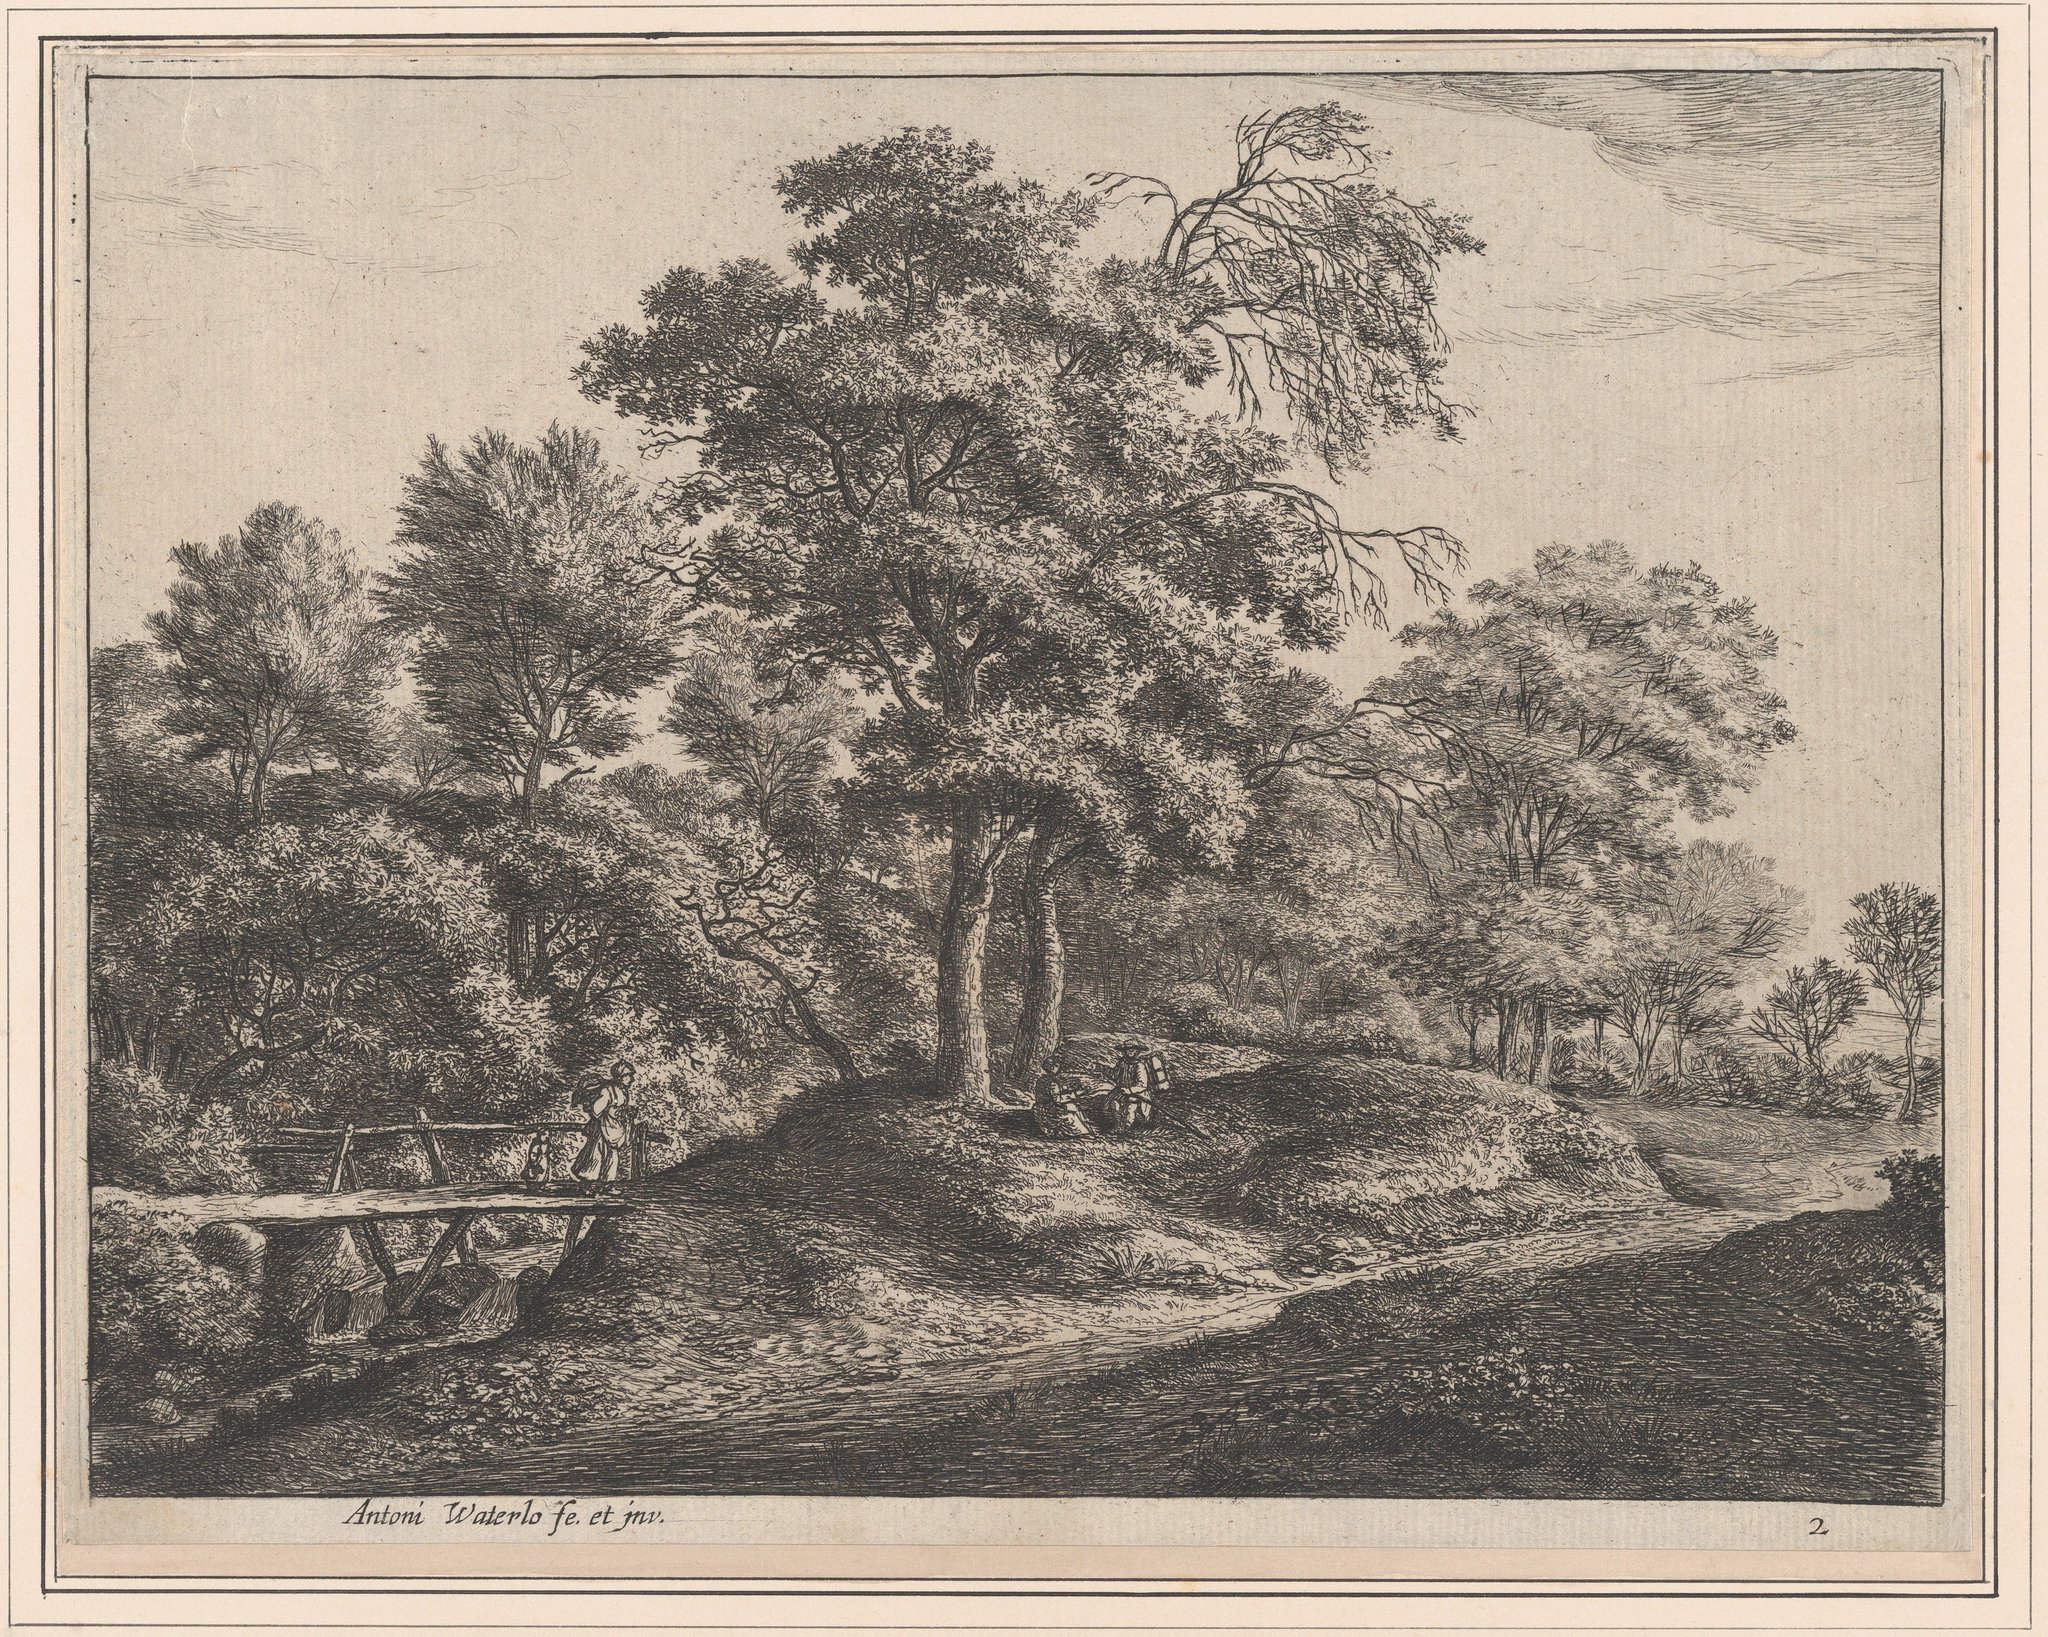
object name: print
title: A Peasant Woman and Daughter on a Small Wooden Bridge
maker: anthonie waterloo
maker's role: artist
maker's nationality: dutch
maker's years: 1609-1690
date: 1601-1700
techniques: etching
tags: bridges,women,trees